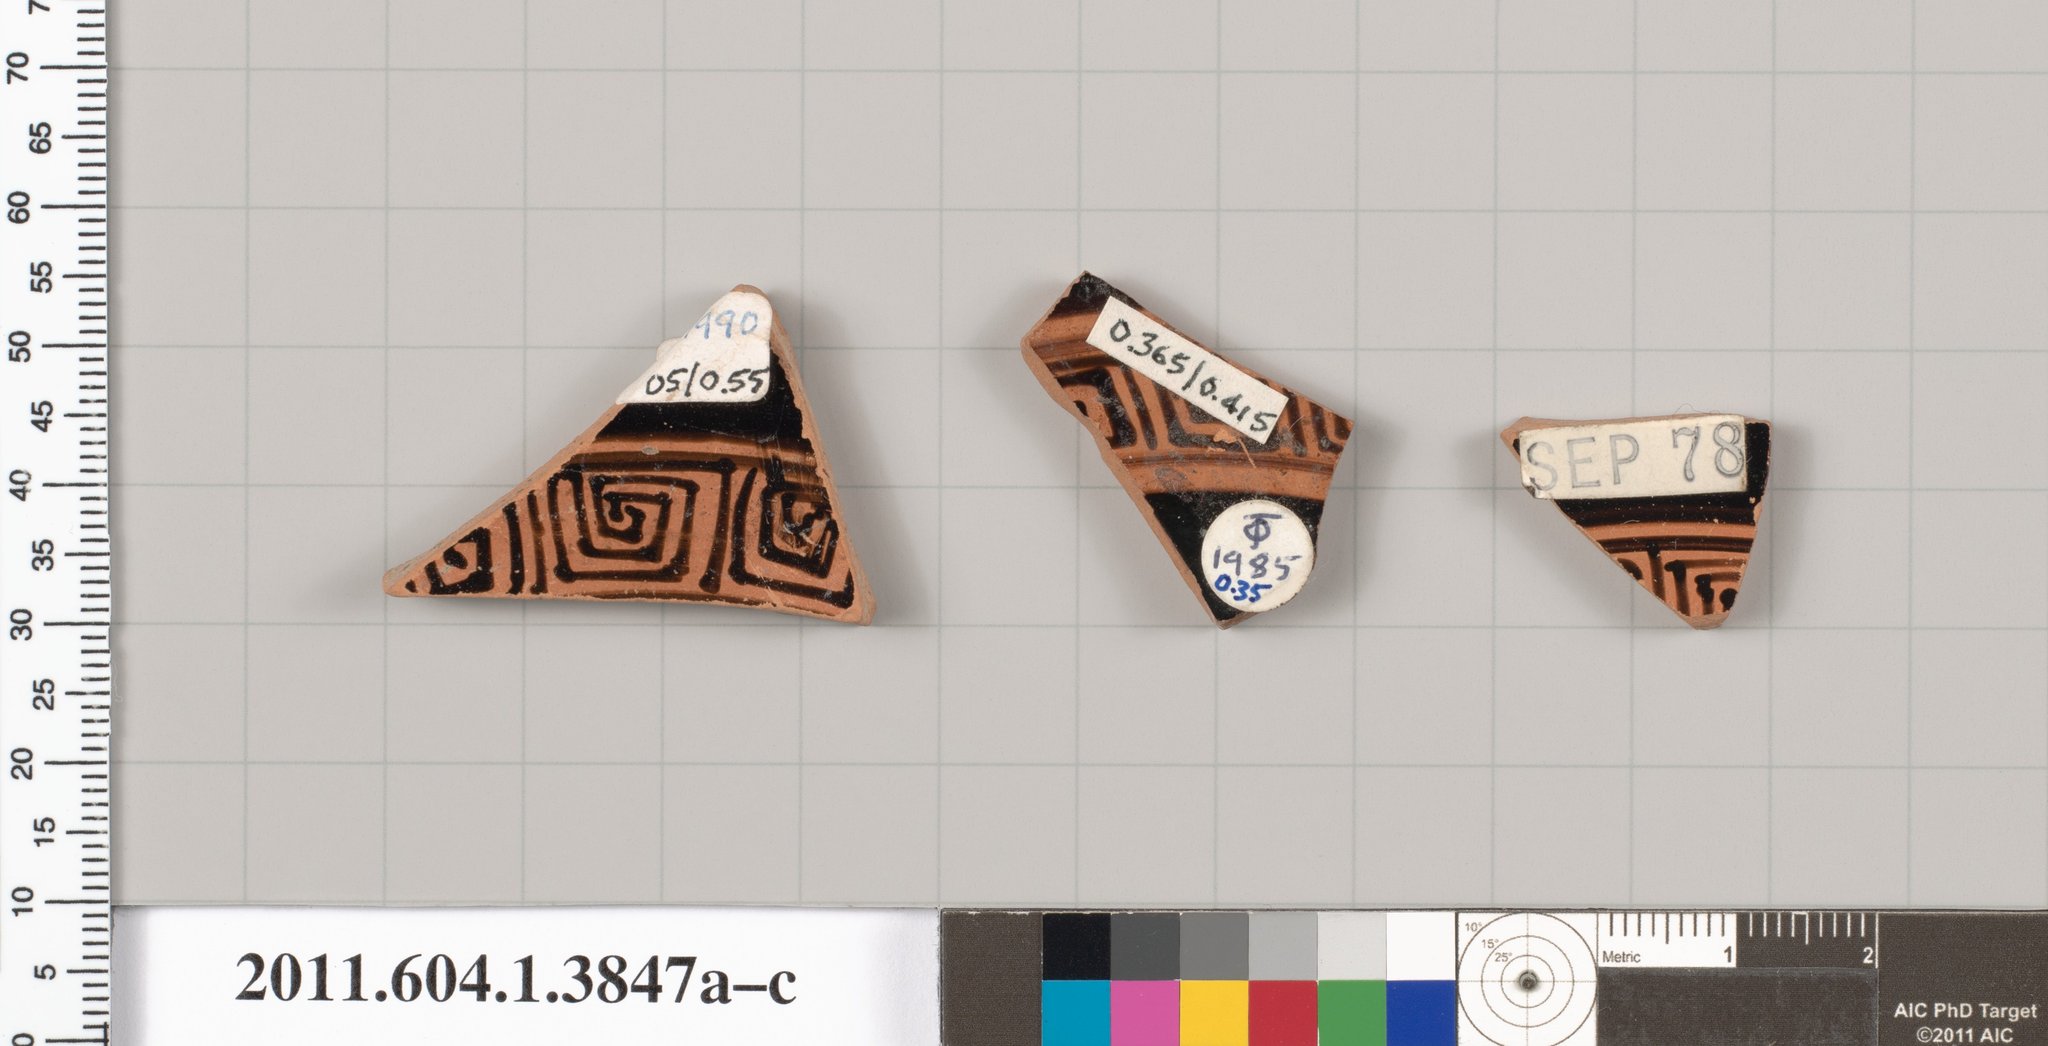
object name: kylix fragment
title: Terracotta fragments of kylikes (drinking cups)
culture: greek, attic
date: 475-451 BCE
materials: terracotta